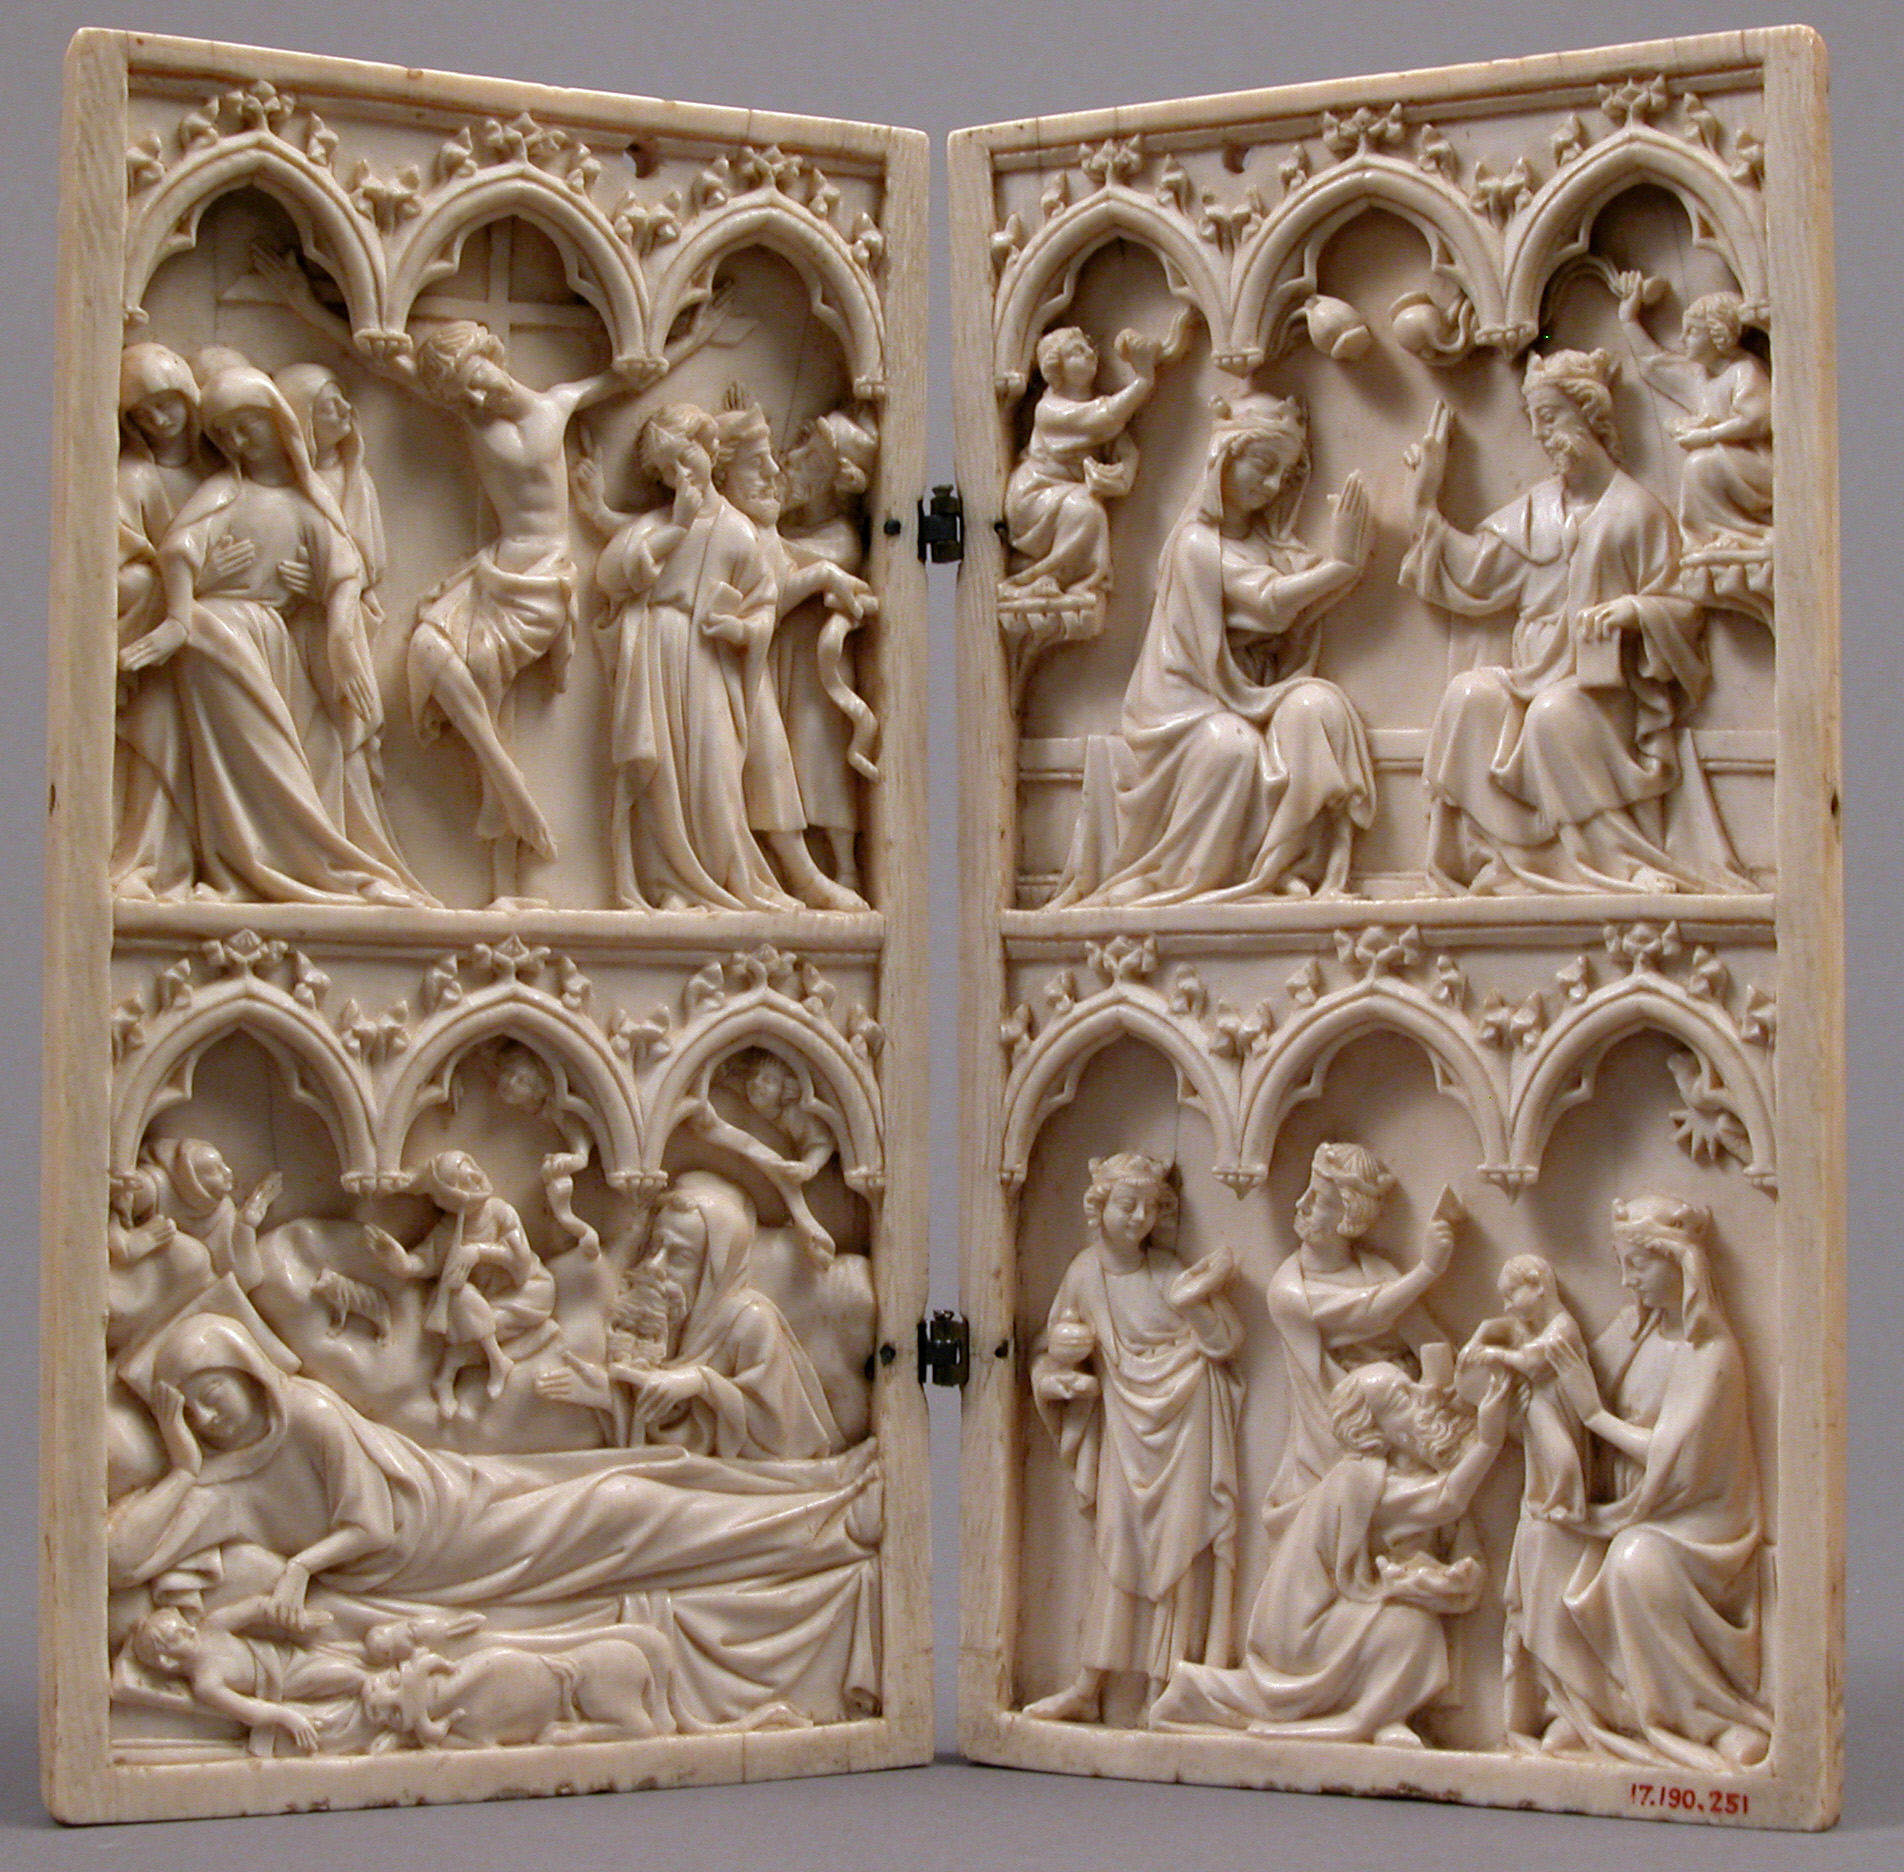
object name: diptych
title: Diptych with Scenes from the Lives of Jesus and Mary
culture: french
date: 1350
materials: ivory, metal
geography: france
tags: christ,virgin mary,adoration of the magi,adoration of the shepherds,crucifixion